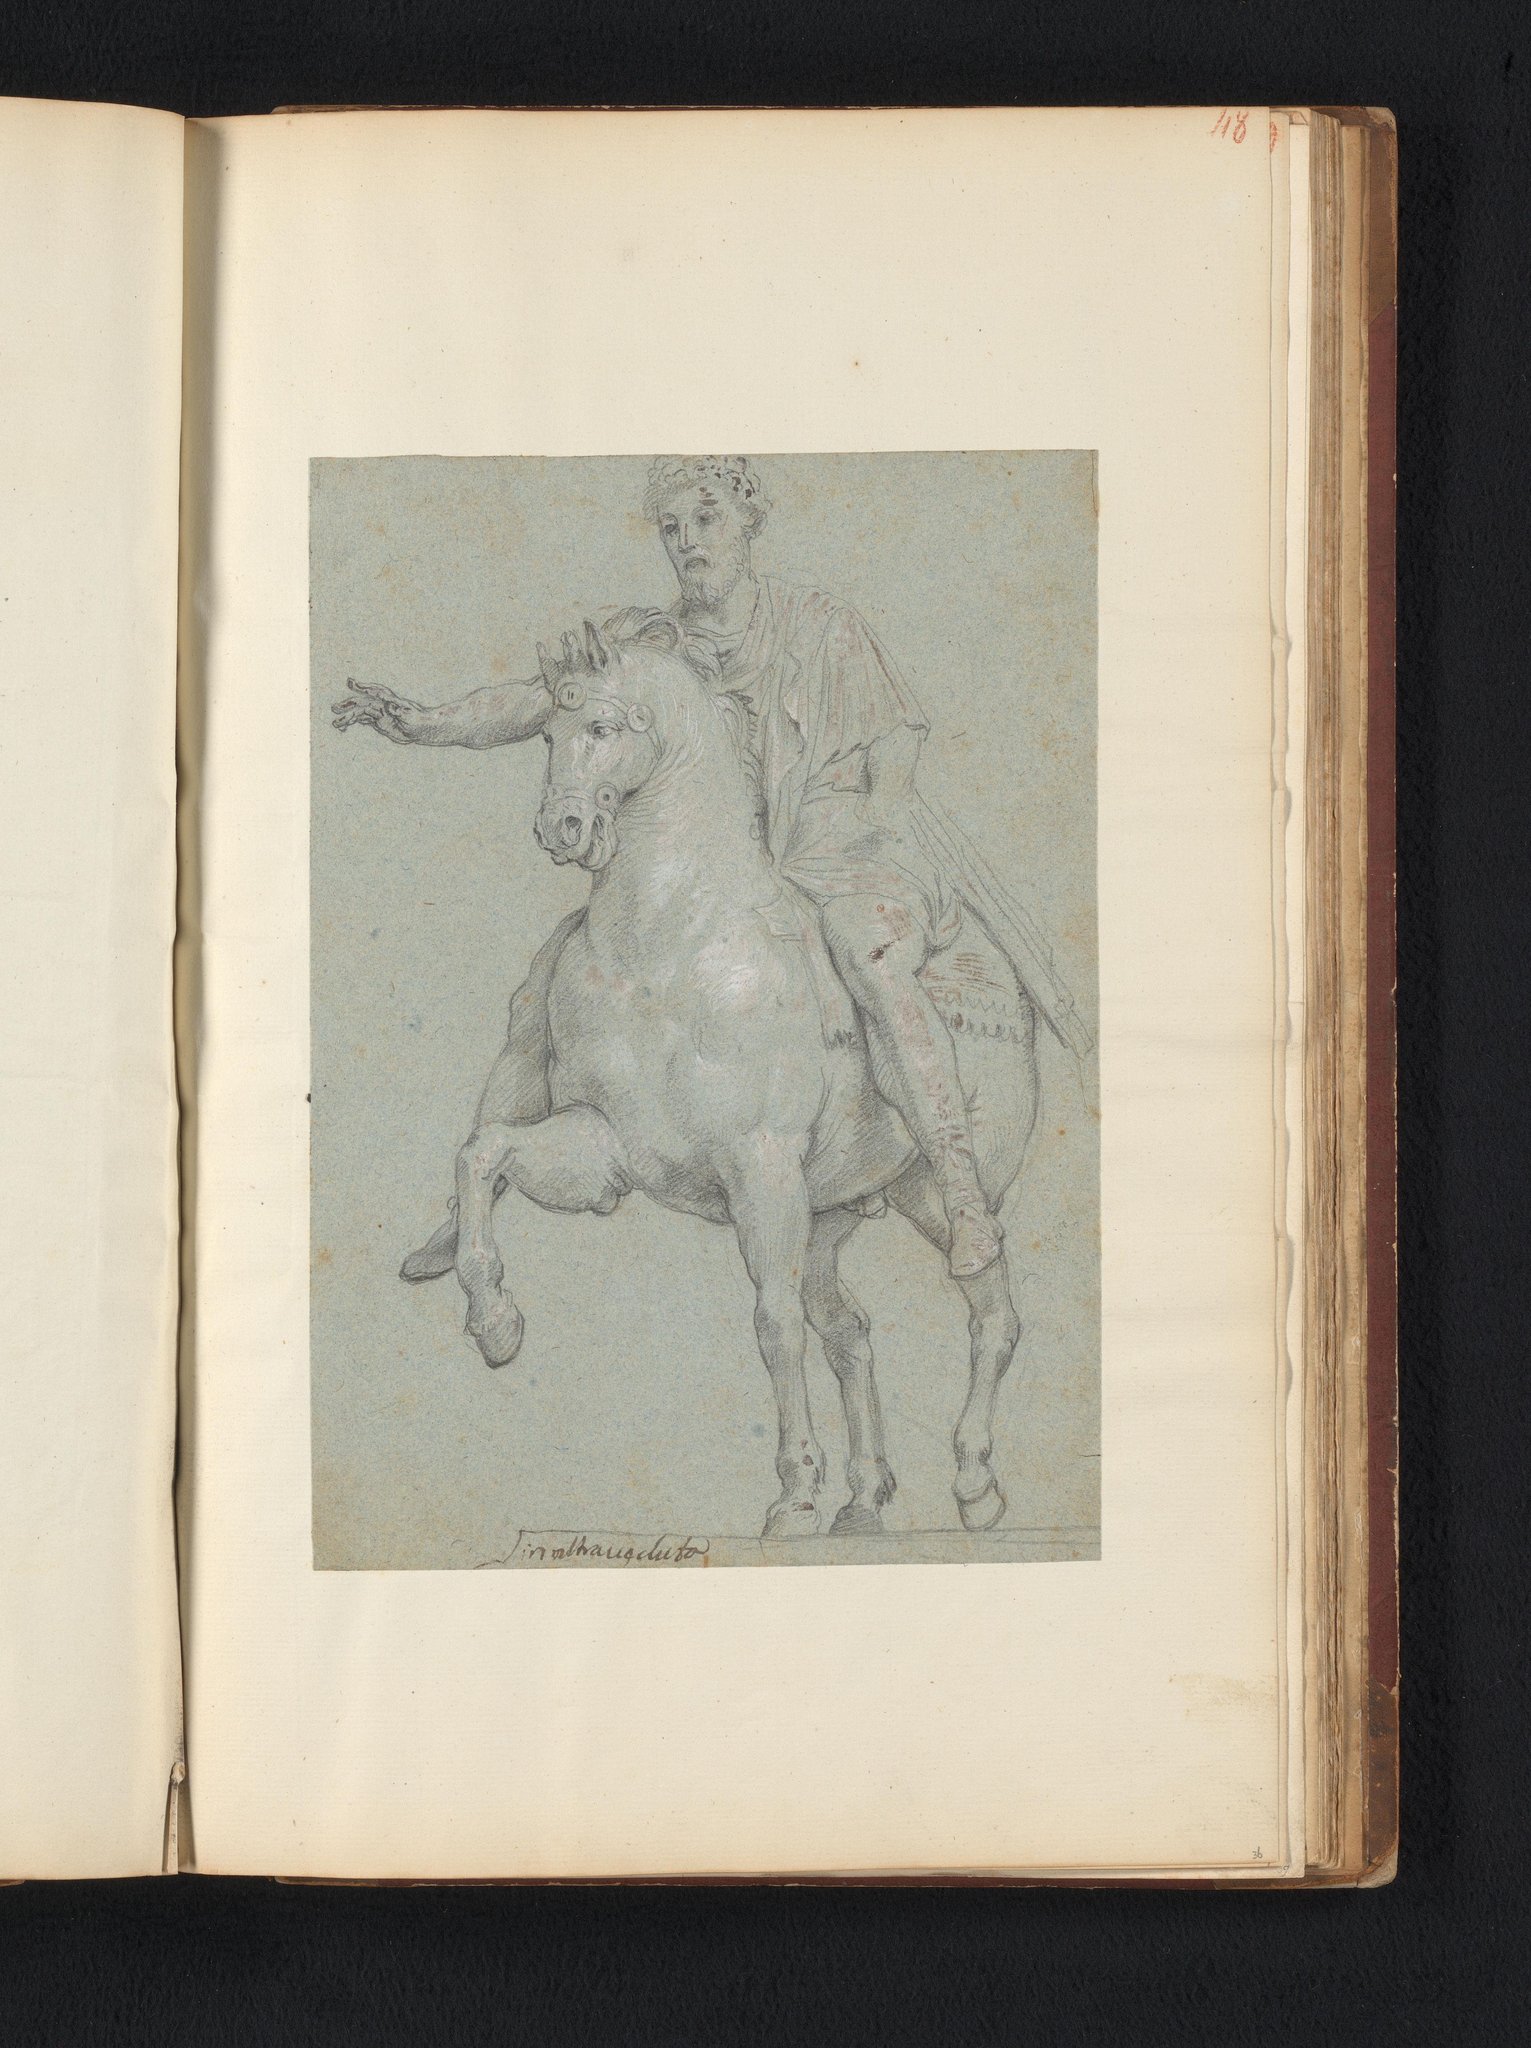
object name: album leaf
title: Ruiterstandbeeld van Marcus Aurelius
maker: Anonymous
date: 1750-1816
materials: chalk, paint, paper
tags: rome, piece of sculpture, reproduction of a piece of sculpture, equestrian statue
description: Ingeplakte tekening van het ruiterstandbeeld van Marcus Aurelius in Rome. Onderdeel van het tweede van twee albums met ingeplakte prenten en tekeningen te dienen als tekenvoorbeelden.